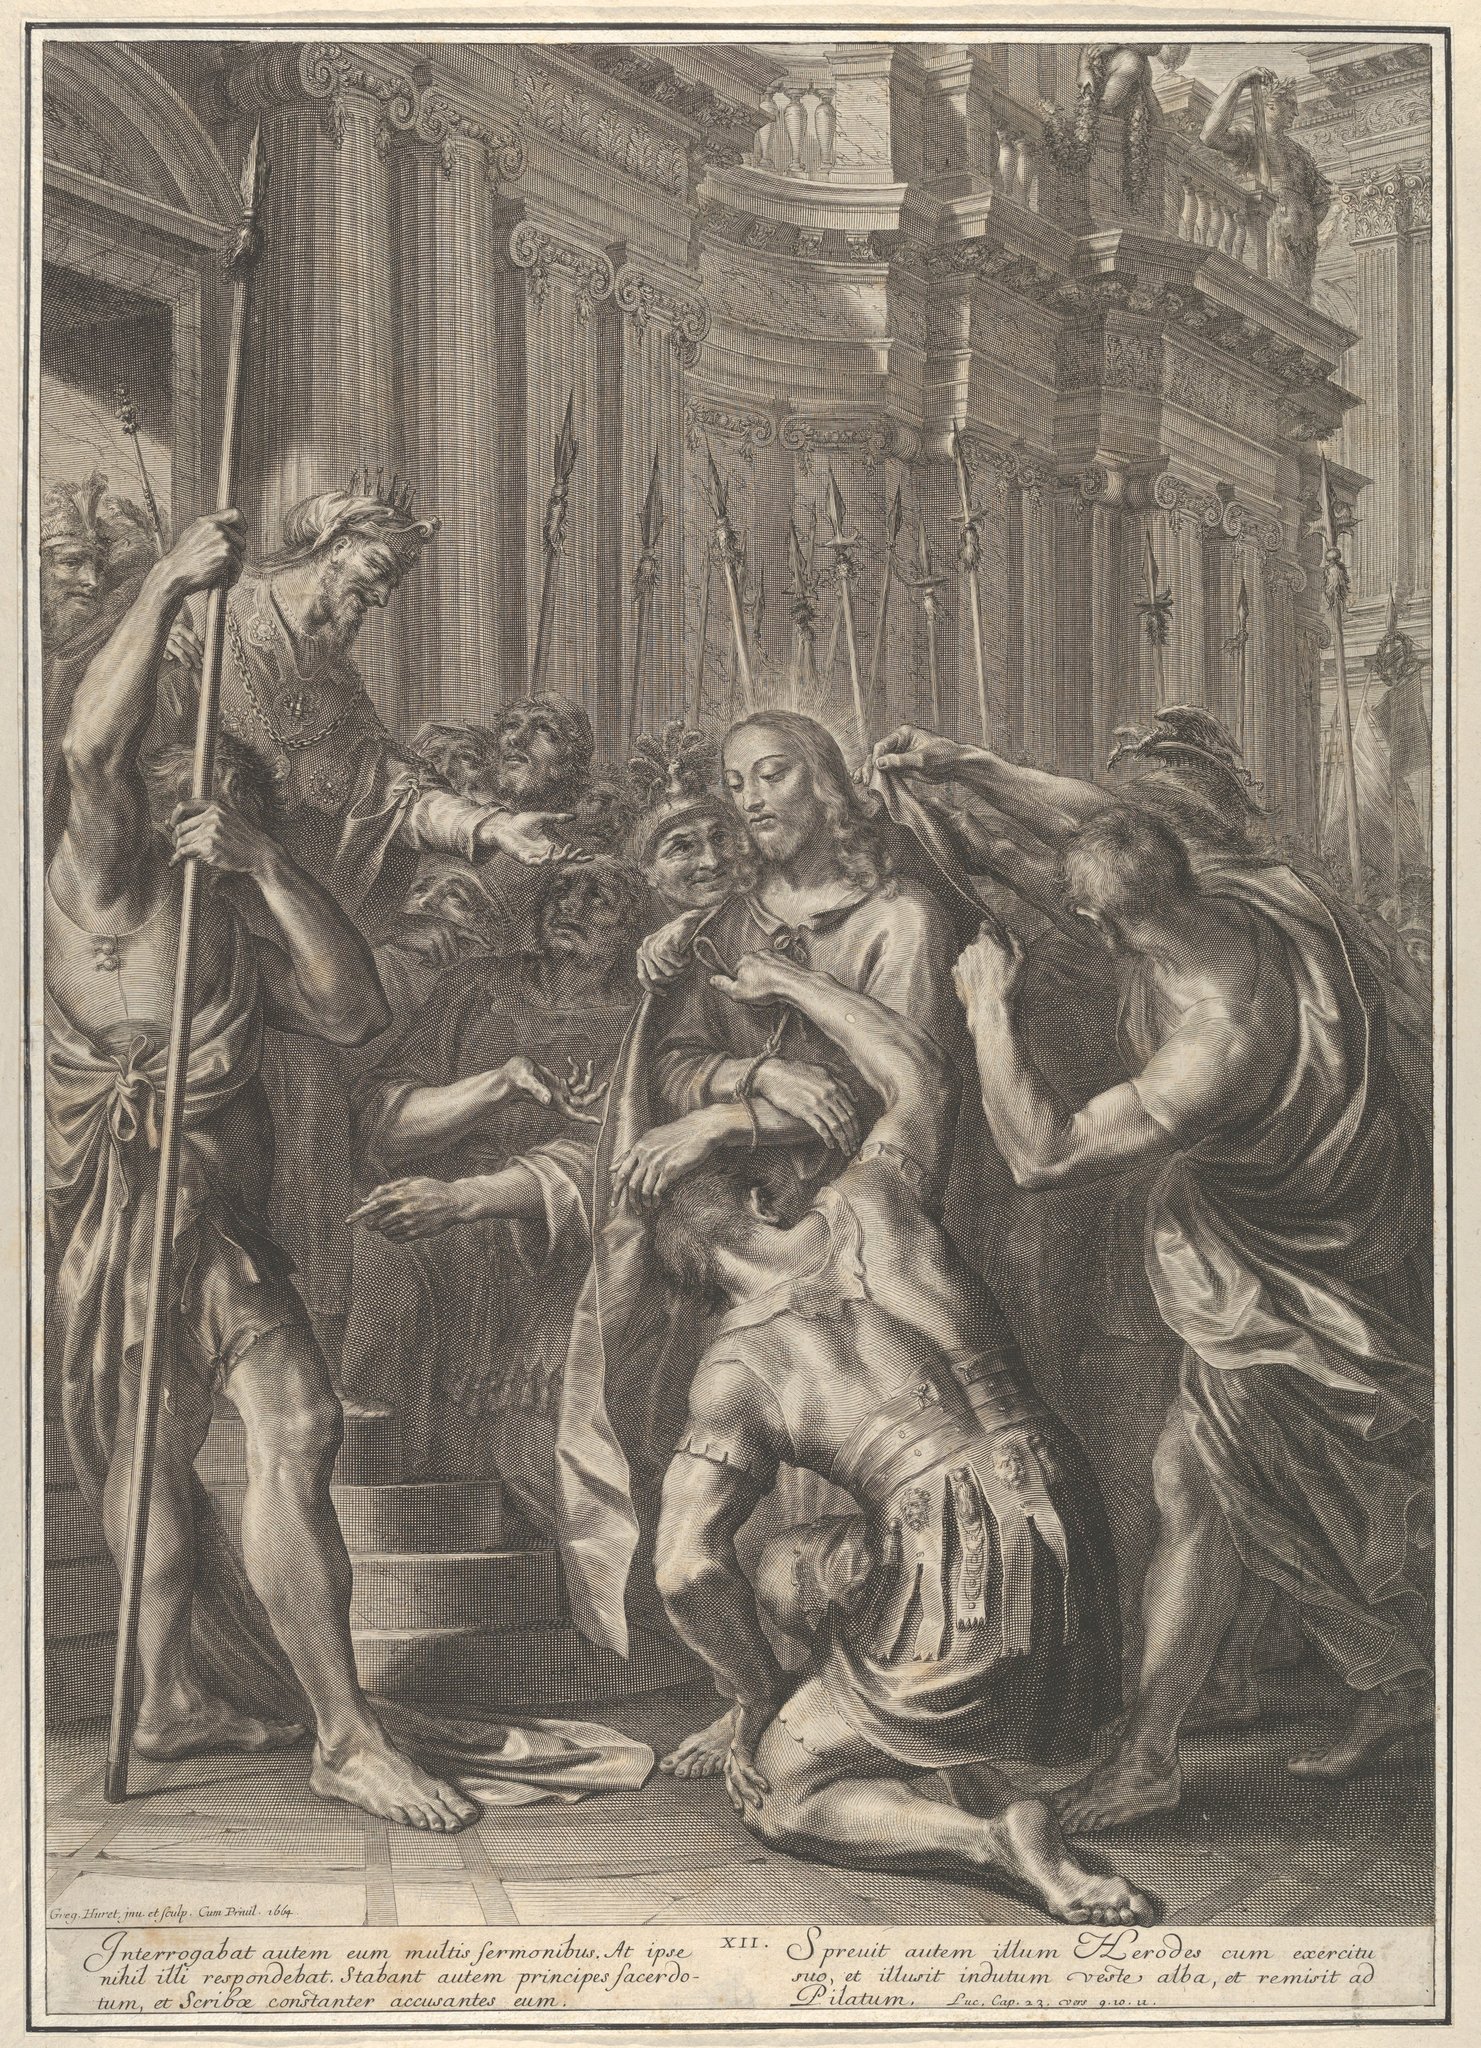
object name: print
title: Christ Before Herod, from The Passion of Christ, plate 12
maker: grégoire huret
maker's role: artist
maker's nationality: french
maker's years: 1606-1670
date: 1664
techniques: engraving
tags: kings,christ